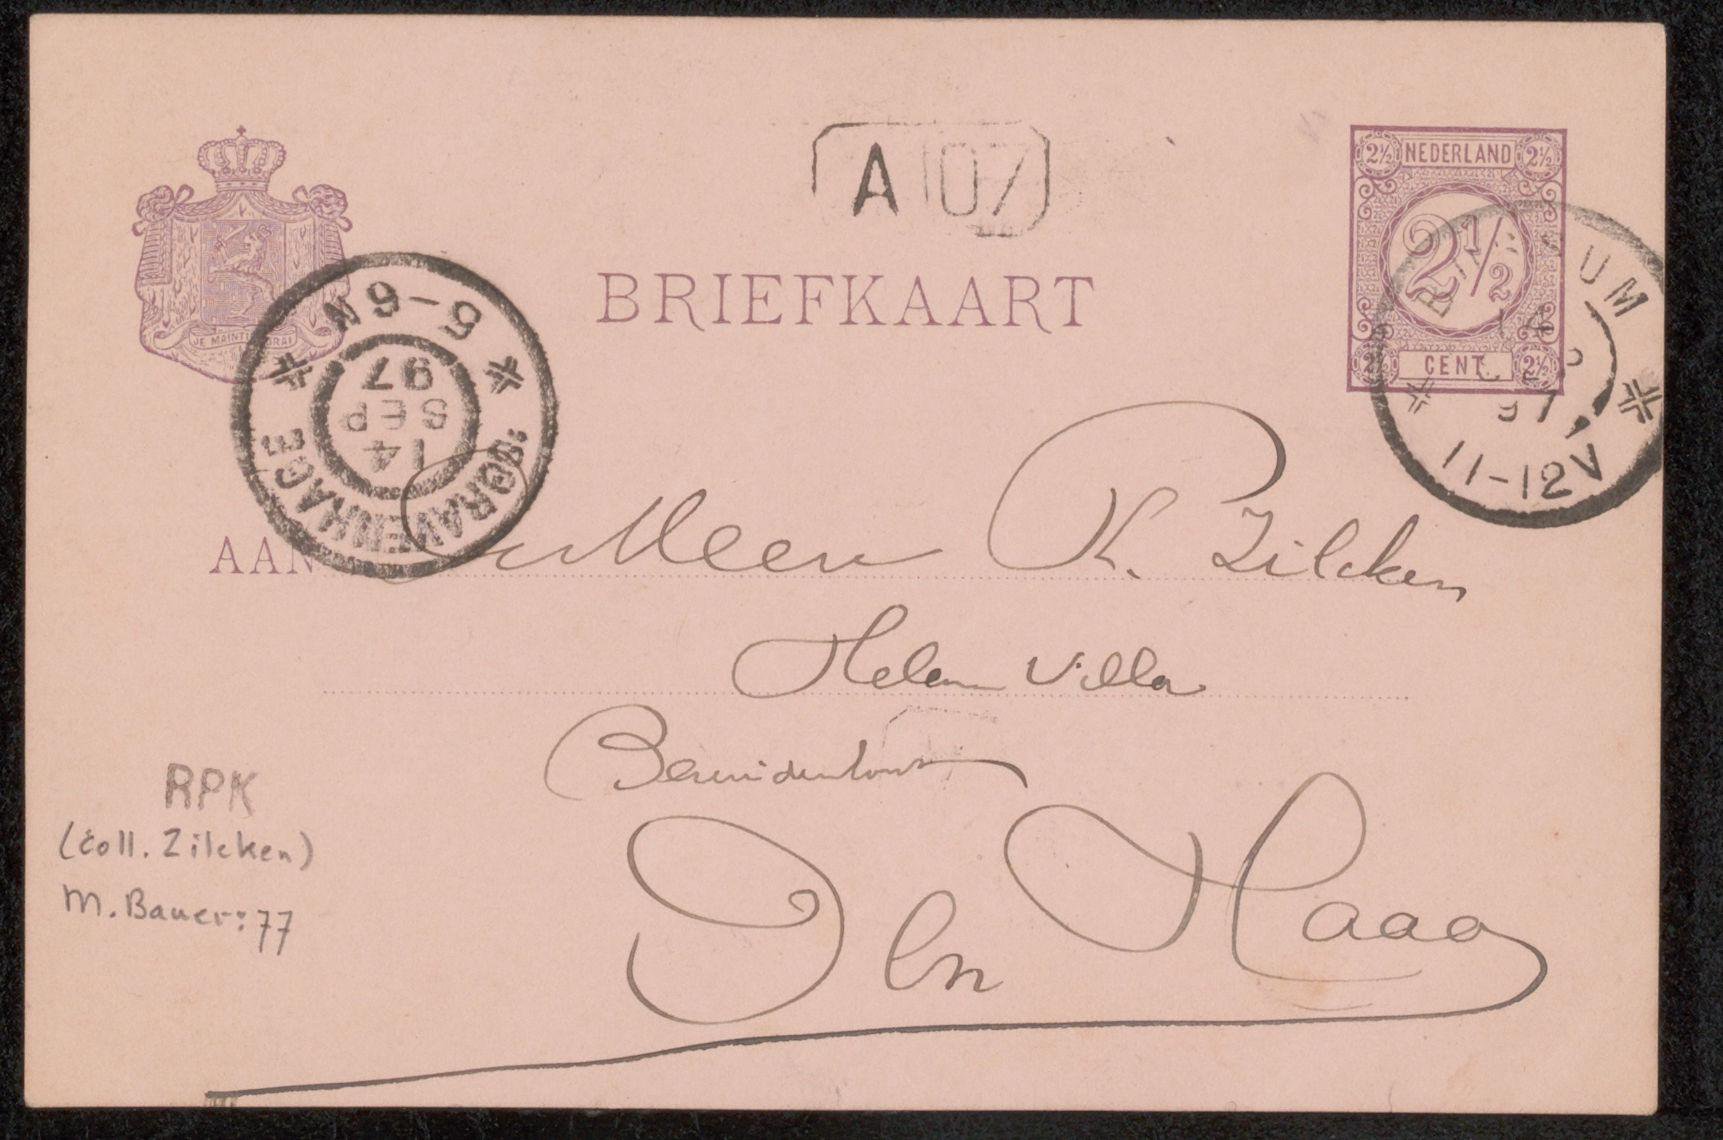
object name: postcard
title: Briefkaart aan Philip Zilcken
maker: marius bauer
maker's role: draughtsman, print maker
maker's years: 1867-1932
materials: cardboard, ink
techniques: pen, writing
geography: bussum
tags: haarlem, frederik van eeden, painter, philip zilcken, the hague, paris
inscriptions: collector's mark: ‘RPK’